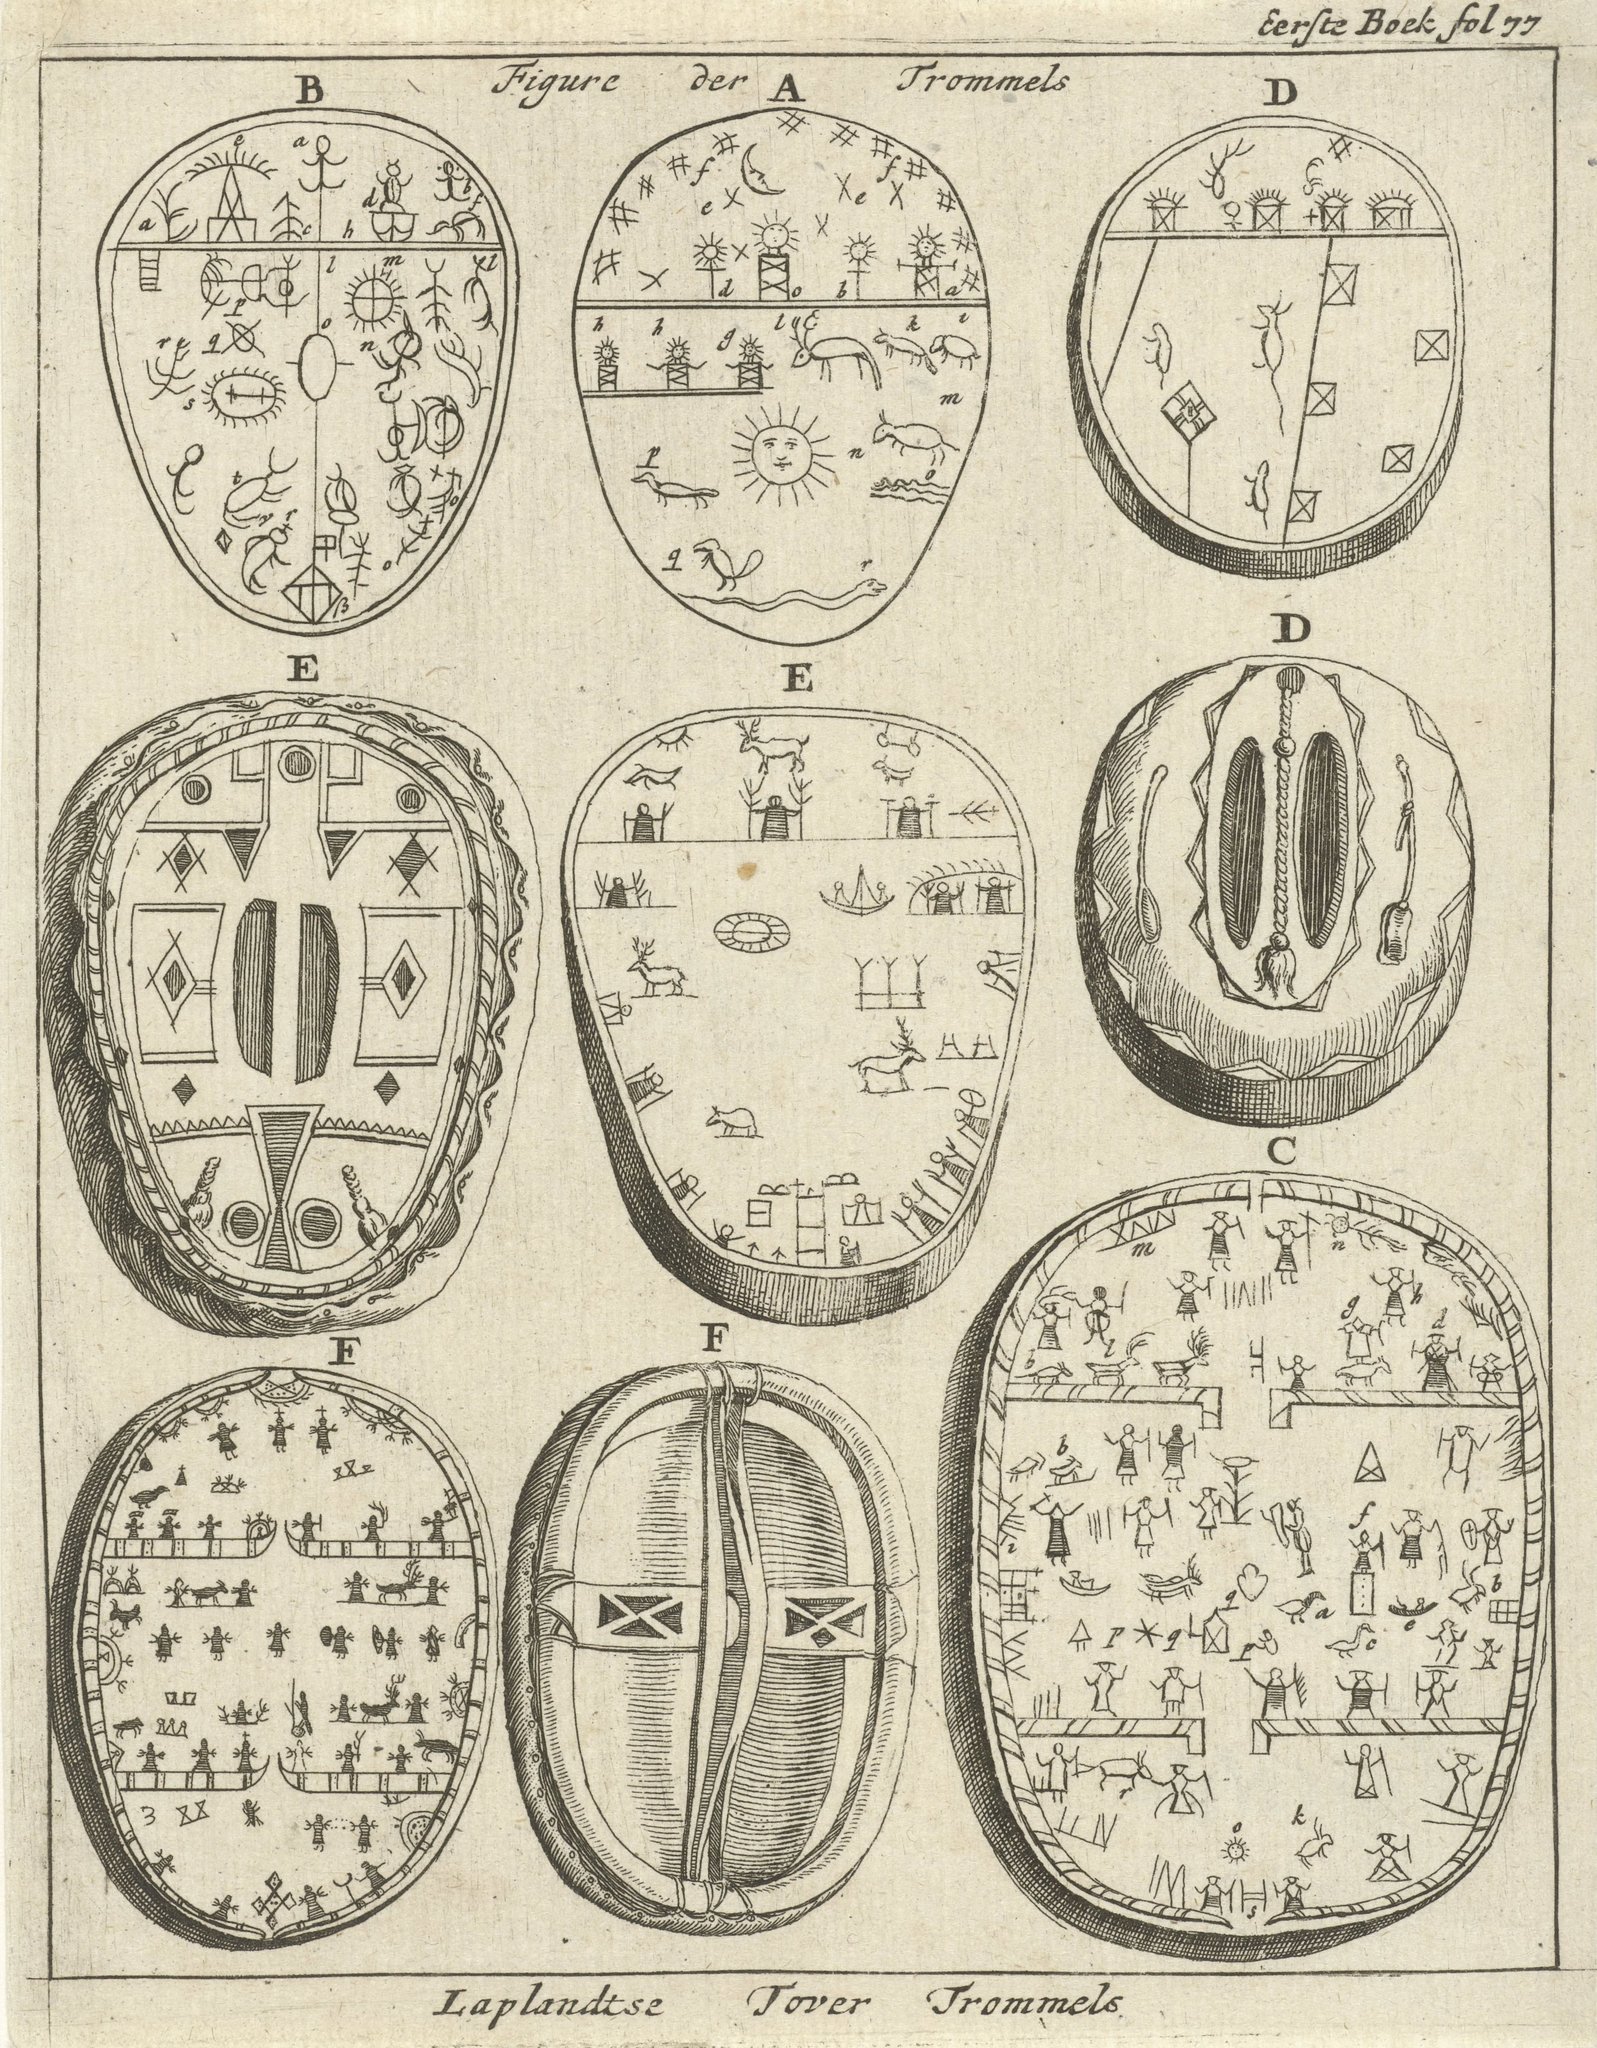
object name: book illustration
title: Laplandtse Tover Trommels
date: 1682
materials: paper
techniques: etching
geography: amsterdam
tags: europeans: sami, drum (musical instrument), sápmi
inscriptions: collector's mark: Lugt 2228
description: Illustratie opgenomen in: Scheffer, Johannes. Waarachtige en aen-merkens-waardige historie van Lapland. Amsterdam: Jan Claesz ten Hoorn, 1682.